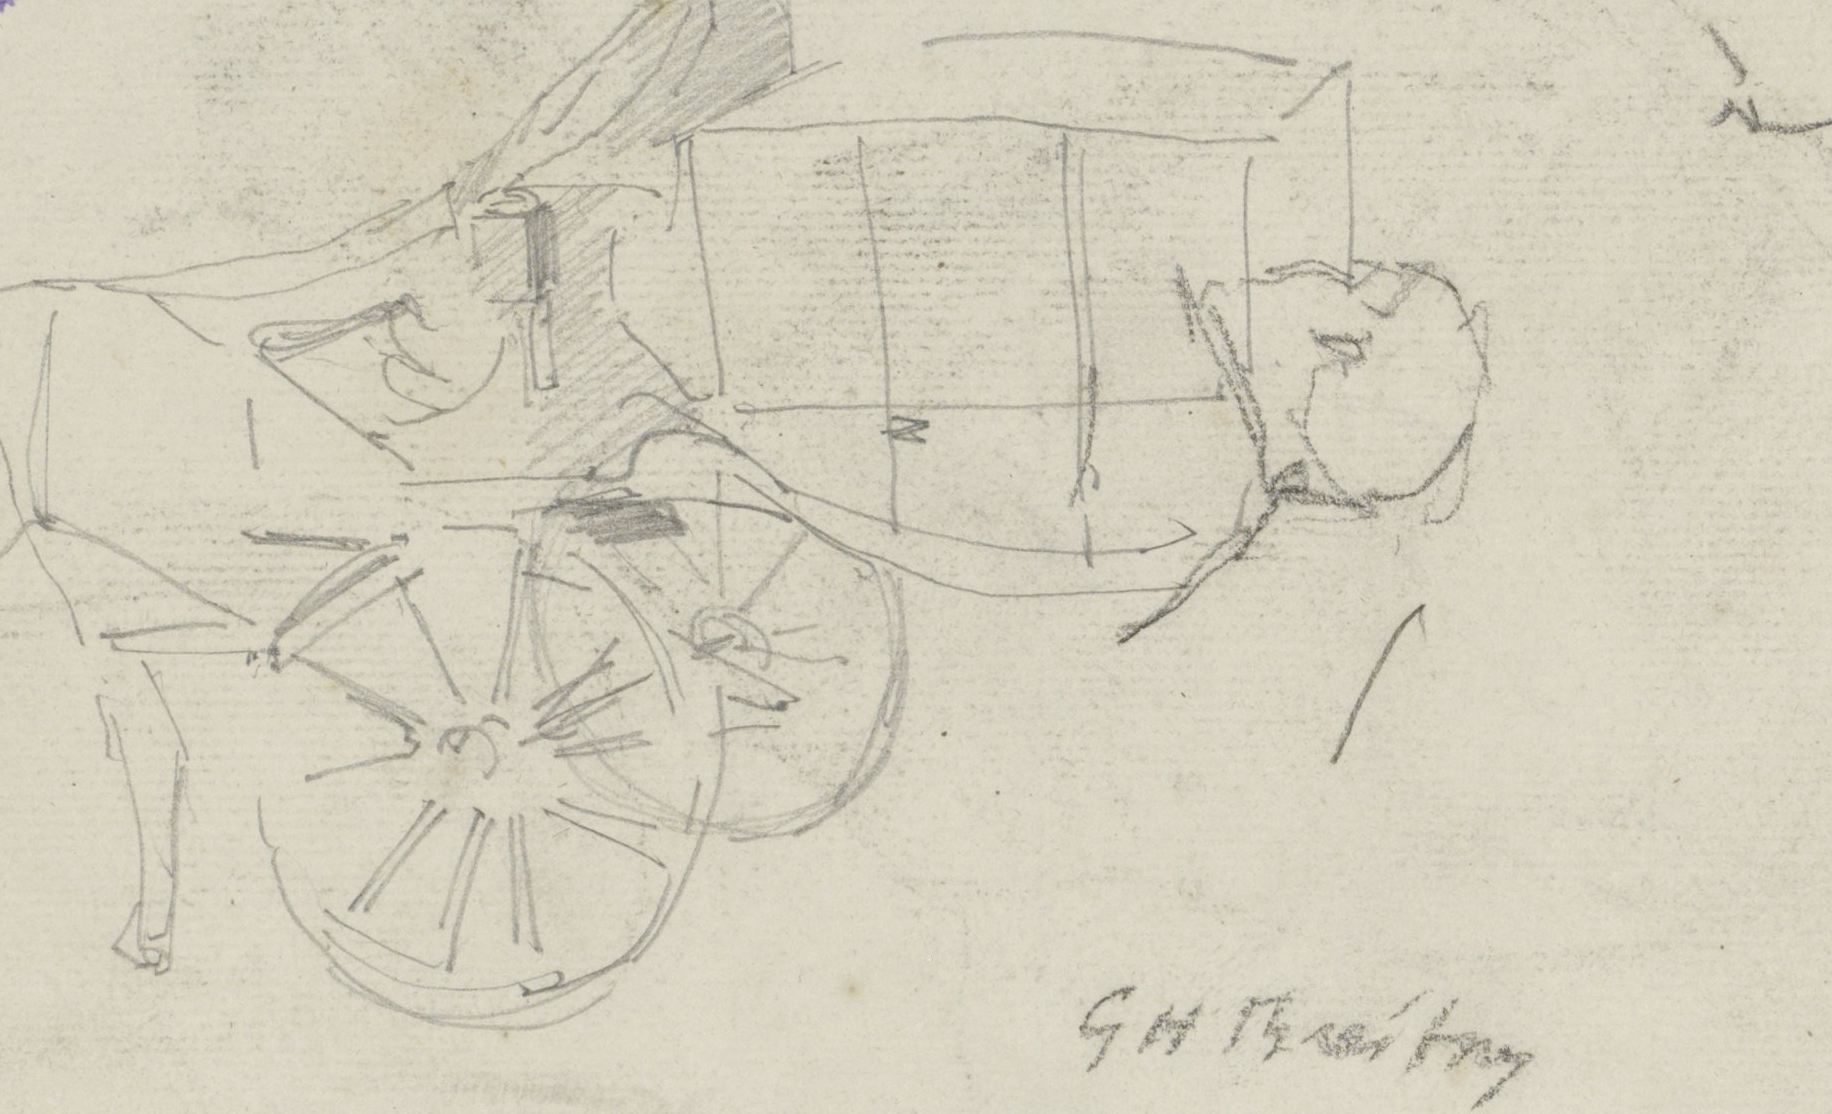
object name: drawing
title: Rijtuig met koetsier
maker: george hendrik breitner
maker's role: draughtsman, painter, print maker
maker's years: 1857-1923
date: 1873-1903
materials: paper, pencil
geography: brussels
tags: four-wheeled, animal-drawn vehicle, e.g.: cab, carriage, coach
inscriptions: workshop stamp: Lugt 291d, signature: ‘G H Breitner’